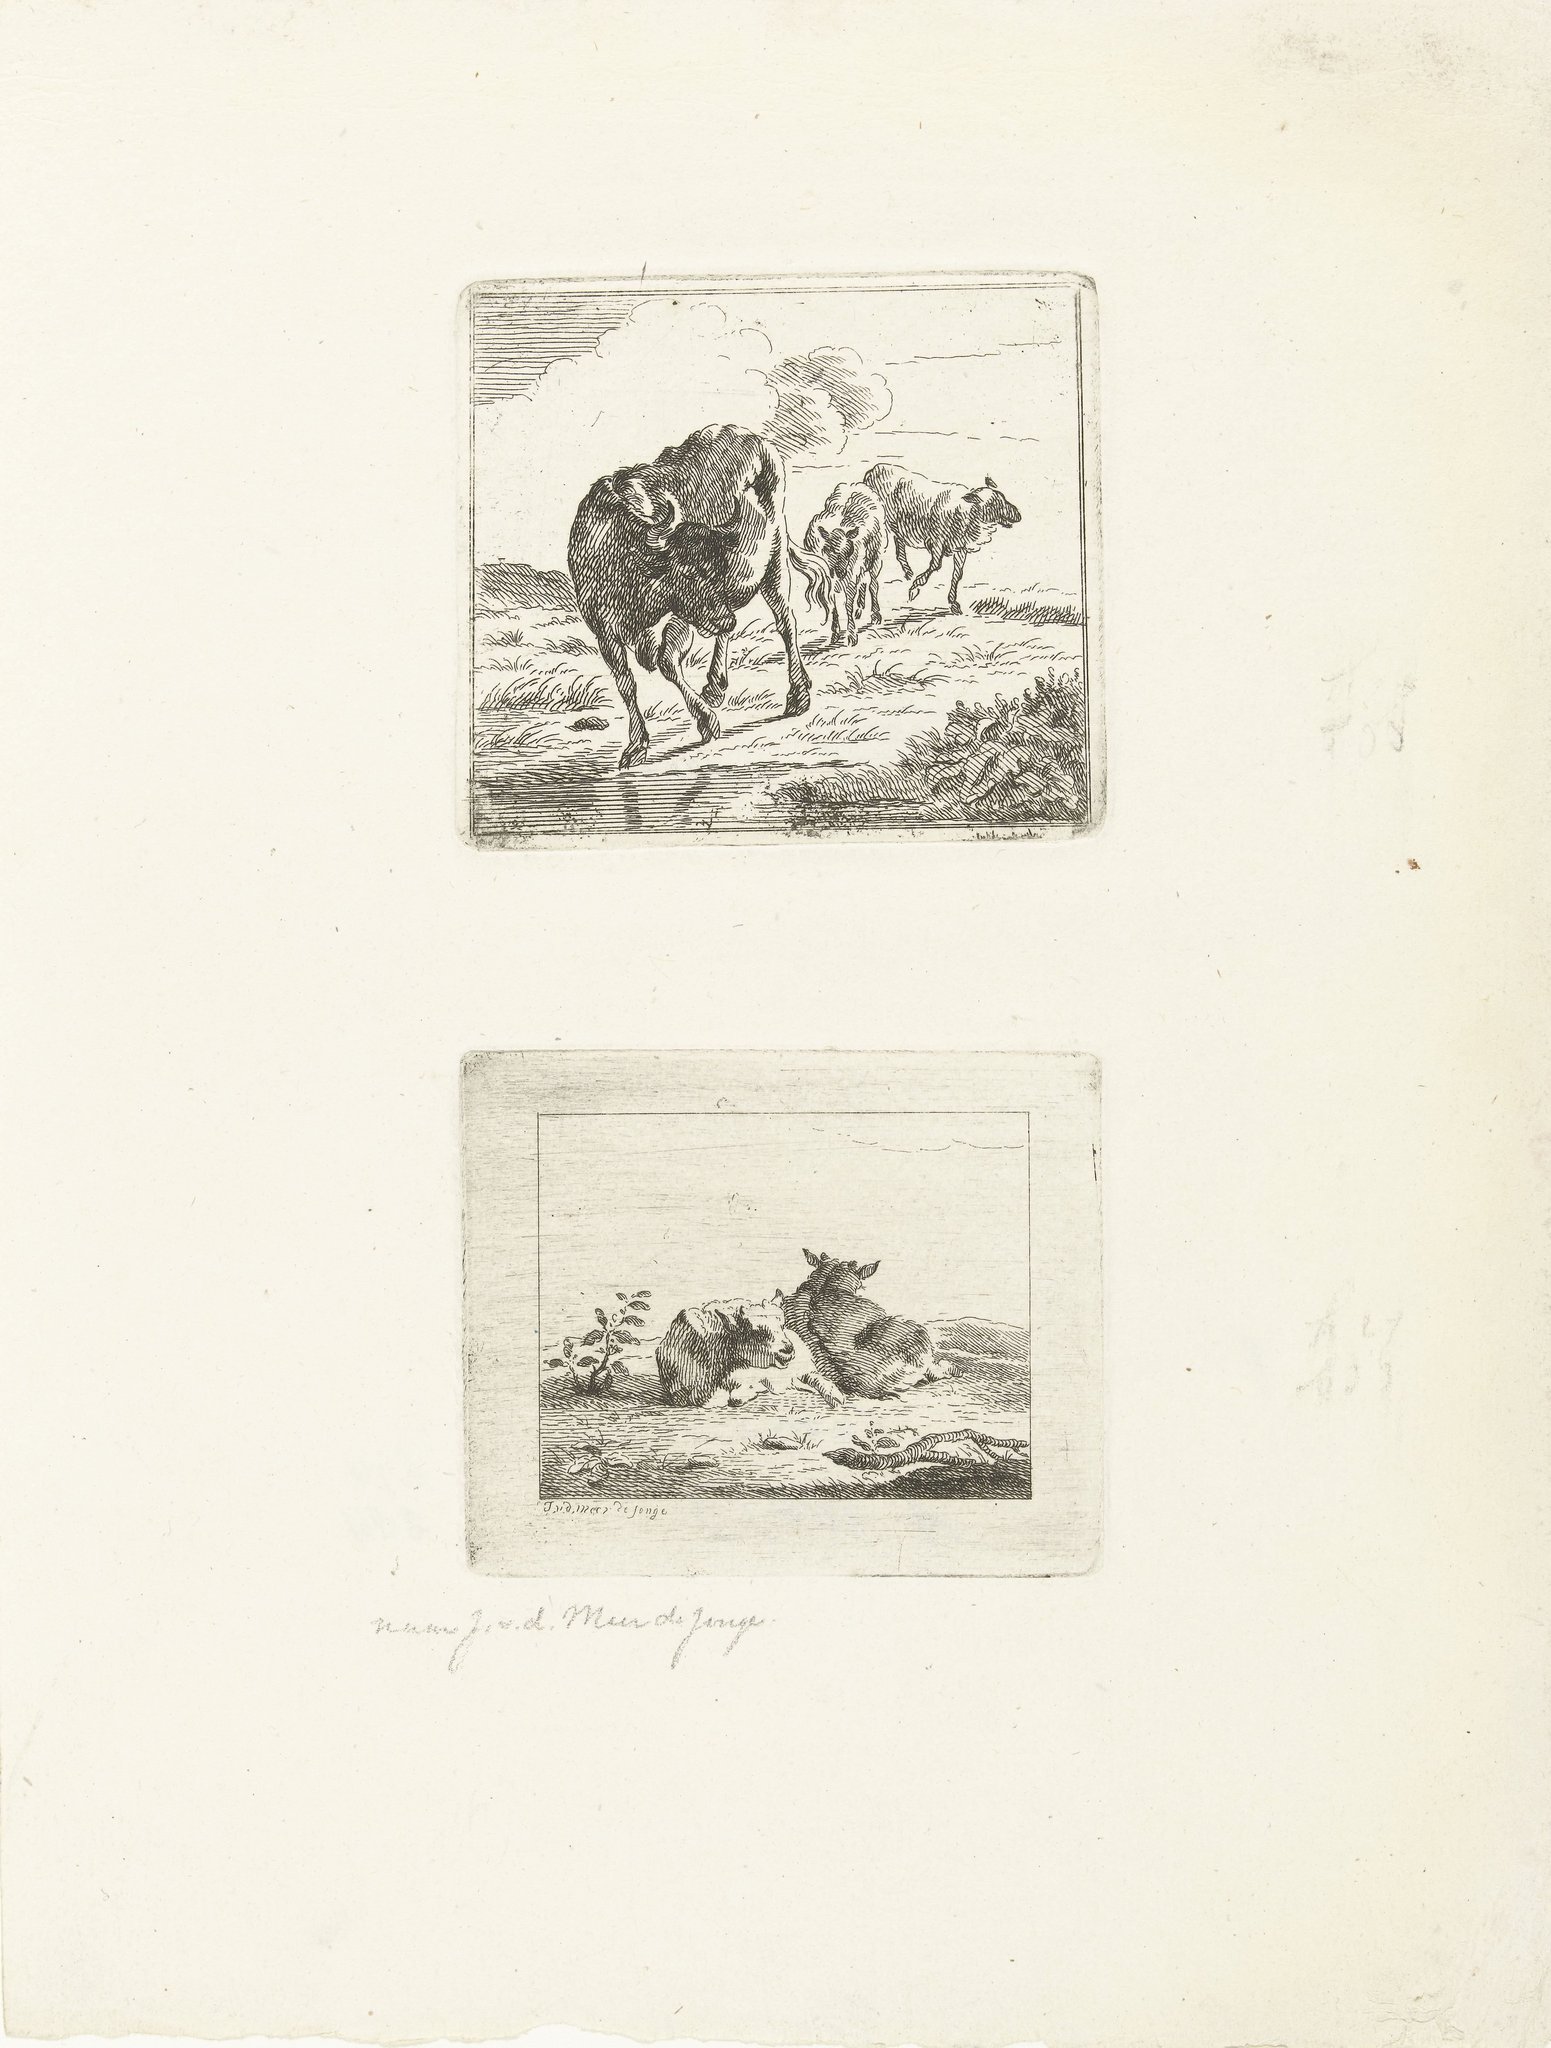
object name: print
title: Twee voorstellingen met koeien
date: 1735-1771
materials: paper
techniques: etching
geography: amsterdam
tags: cow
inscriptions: collector's mark: Lugt 2228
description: Twee platen afgedrukt op een vel papier: boven drie koeien bij een water, onder twee slapende koeien.